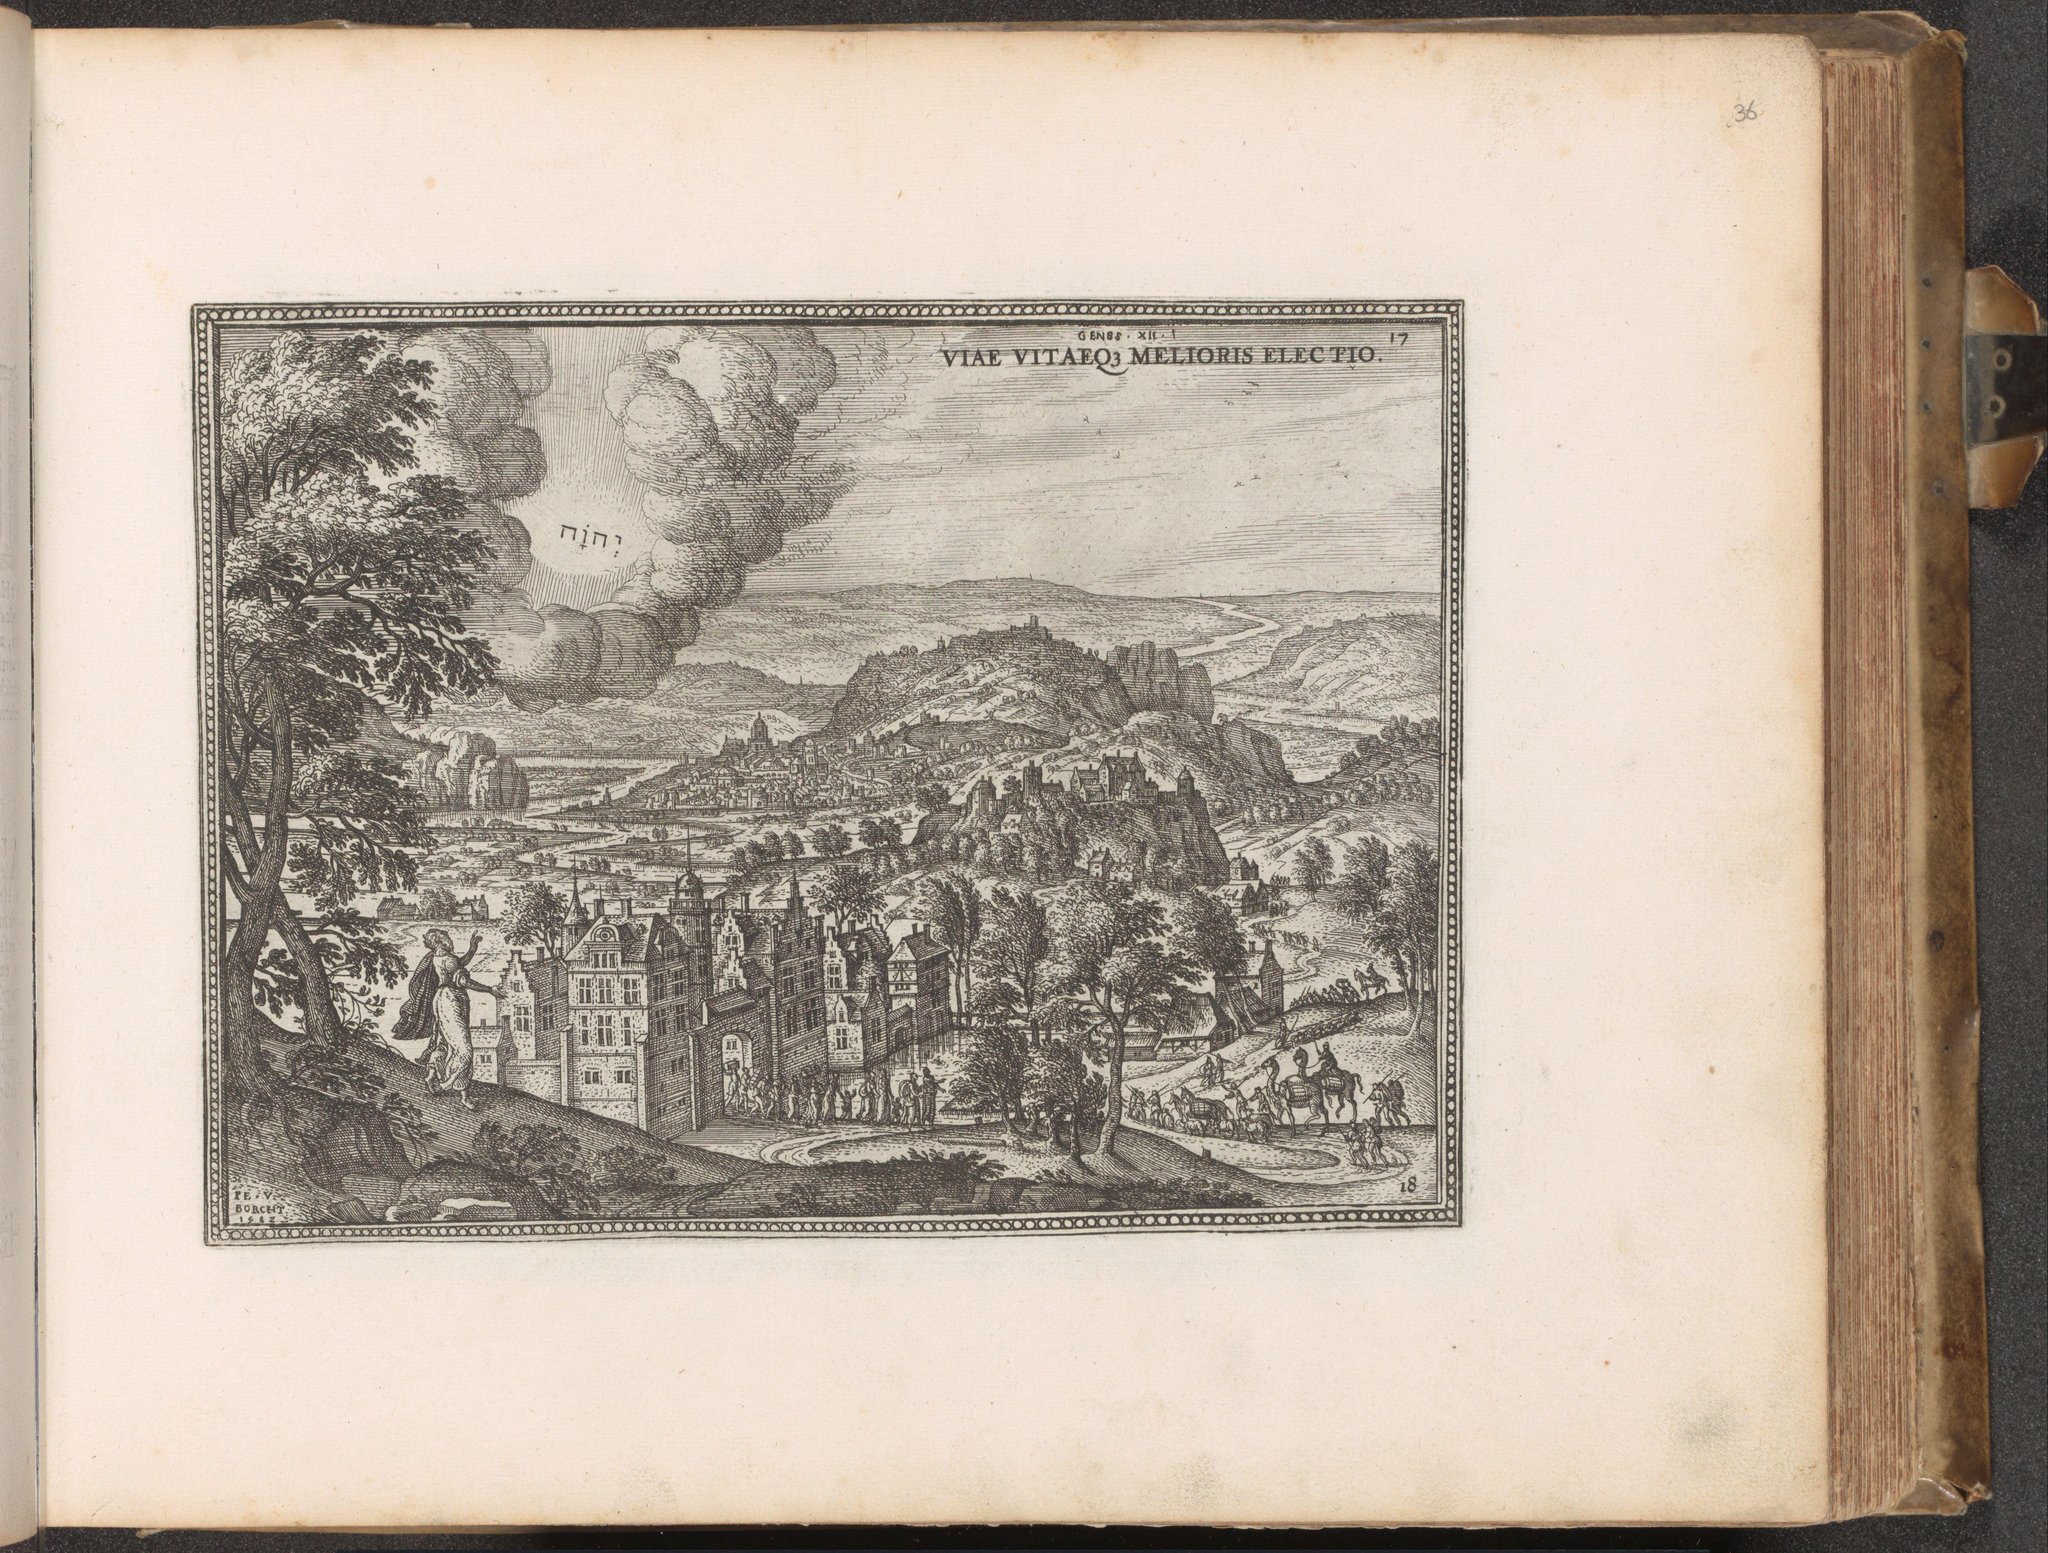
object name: album leaf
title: Imagines et figurae bibliorum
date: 1582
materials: paper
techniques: etching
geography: amsterdam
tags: tetragram (in roman or hebrew script) ~ symbol of god the father, old testament, abraham communicating with god (in general), abraham goes to canaan (genesis 12:1-9)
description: God verschijnt voor Abraham en bespreekt met hem het verbond dat hij wil aangaan met zijn volk. Het tetragram staat symbool voor God de Vader. Op de achtergrond vertrekt Abraham met zijn familie naar Kanaän (Gen. 12: 1). De prent maakt deel uit van een album.